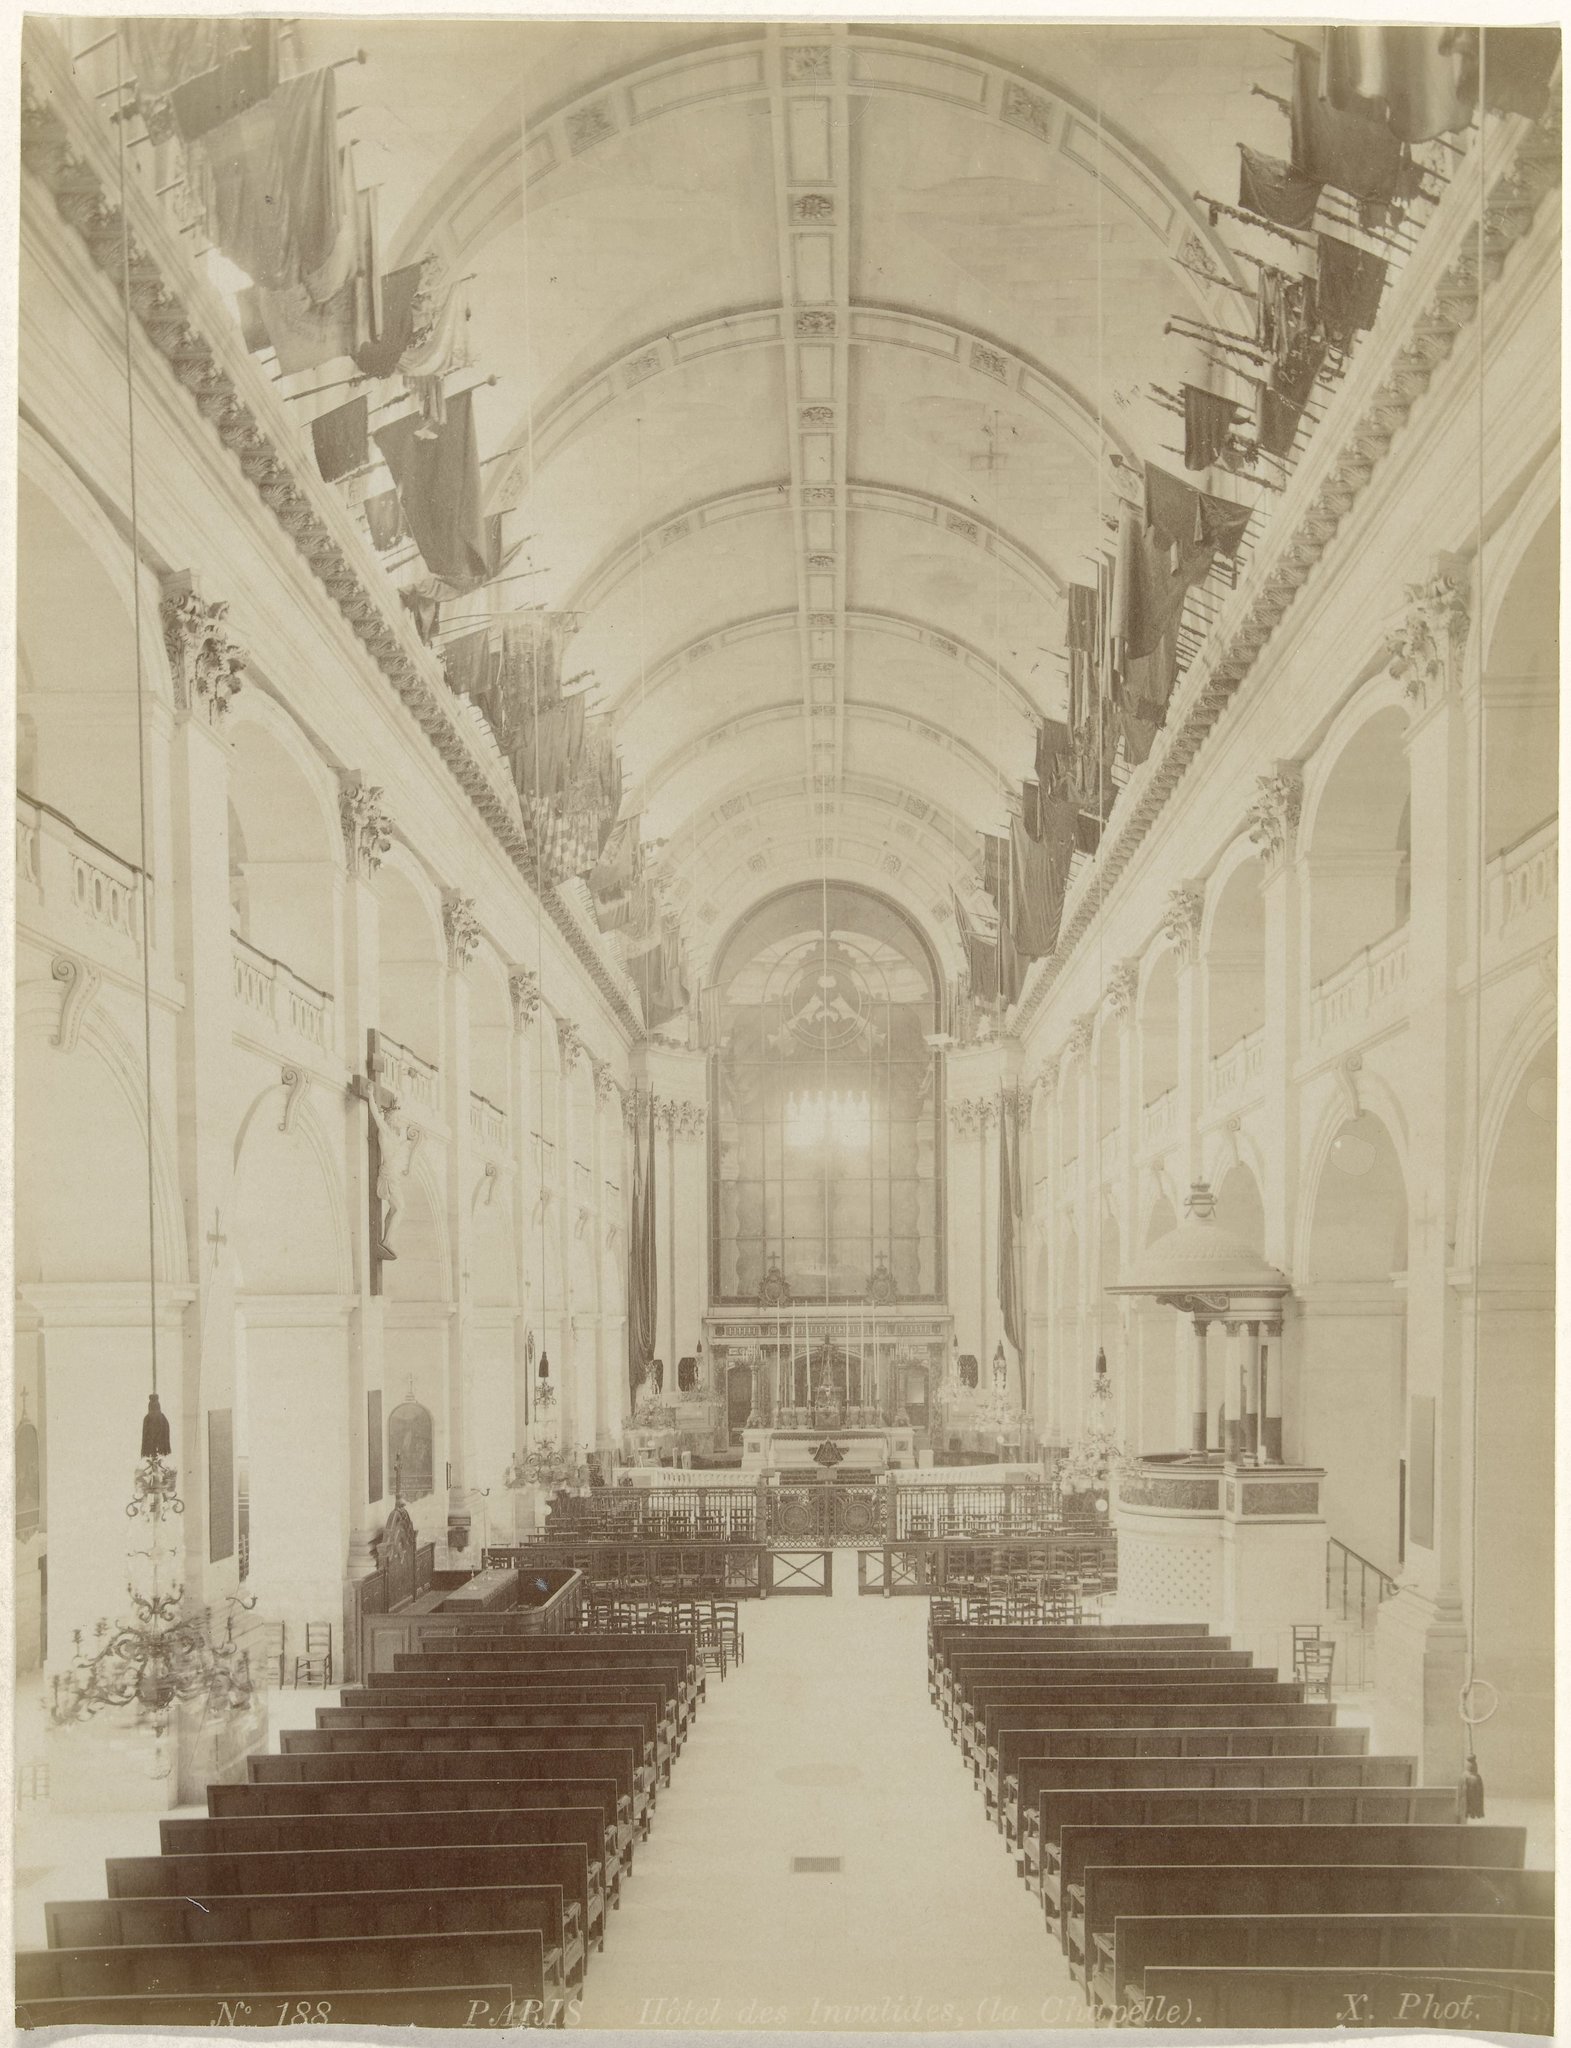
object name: photograph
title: Kapel in het Hôtel des Invalides, Parijs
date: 1887-1900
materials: paper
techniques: albumen print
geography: paris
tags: interior of church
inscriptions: inscription: ‘No. 188 Paris Hôtel des Invalides, (la Chapelle). X. Phot.’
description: Tussen 1887 en ca. 1900 werkten Neurdein frères onder andere onder de naam 'X phot.'.